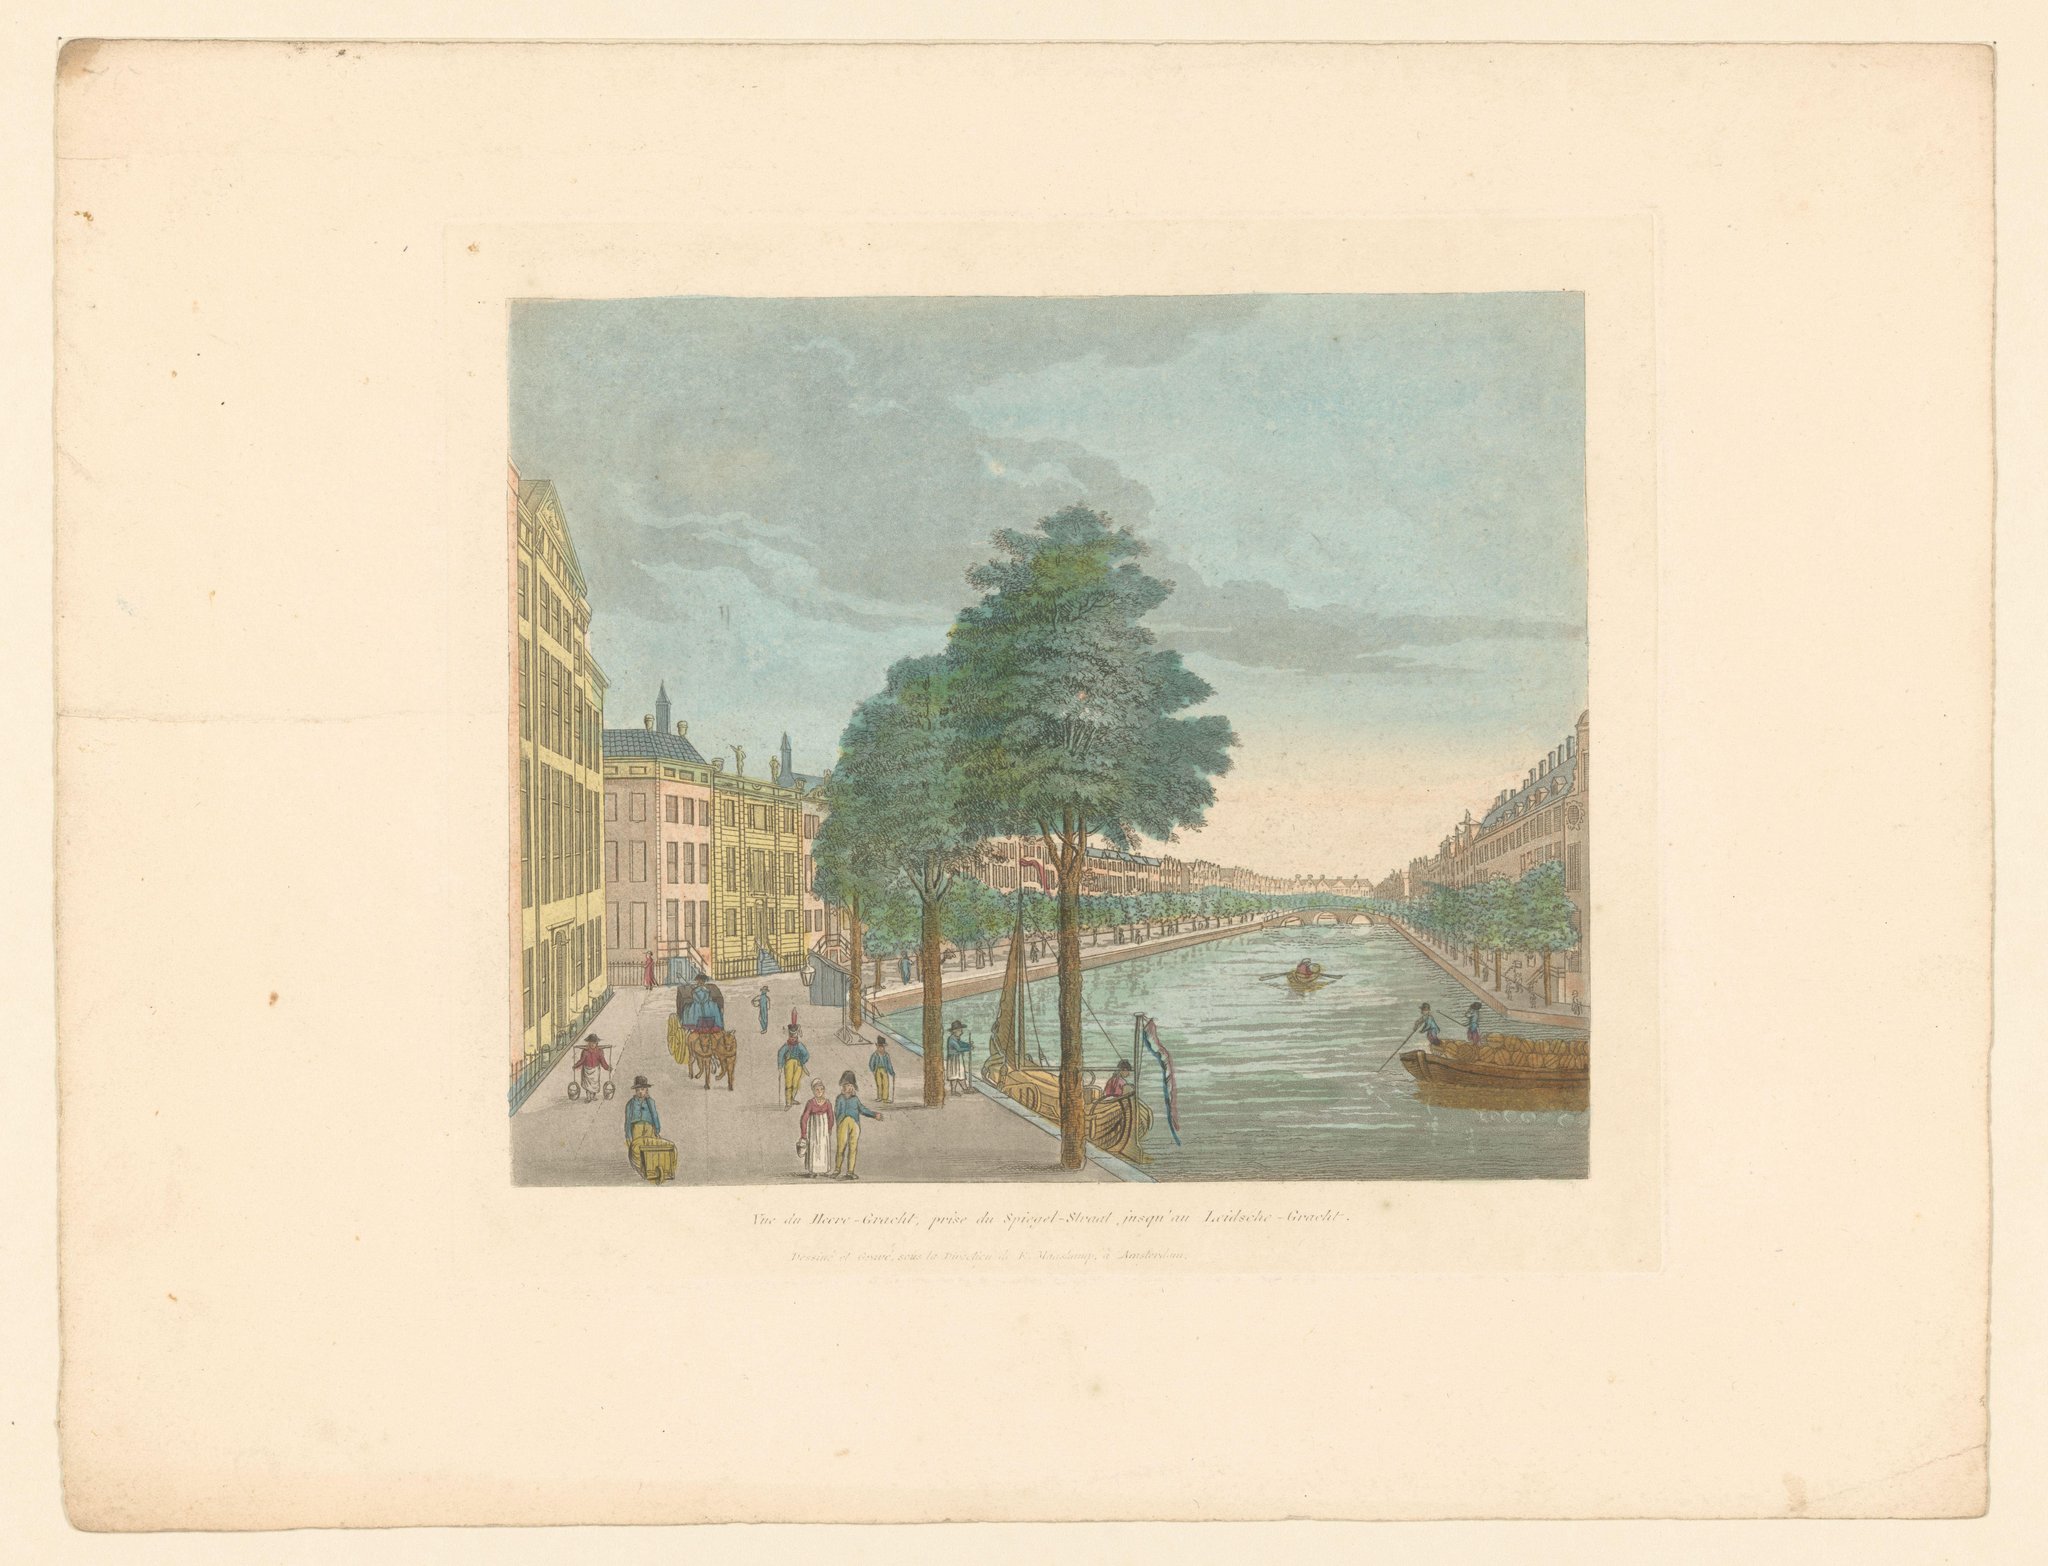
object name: print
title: Gezicht op de Herengracht bij de Spiegelstraat in Amsterdam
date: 1810-1813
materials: paper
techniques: aquatint, etching, hand coloring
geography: amsterdam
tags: canals, waters (in city)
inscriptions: collector's mark: Lugt 2228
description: Prent verschenen in: Nouvelle statistique historique d'Amsterdam, ou Le guide du voyageur en cette ville. Amsterdam: Evert Maaskamp, [1815].